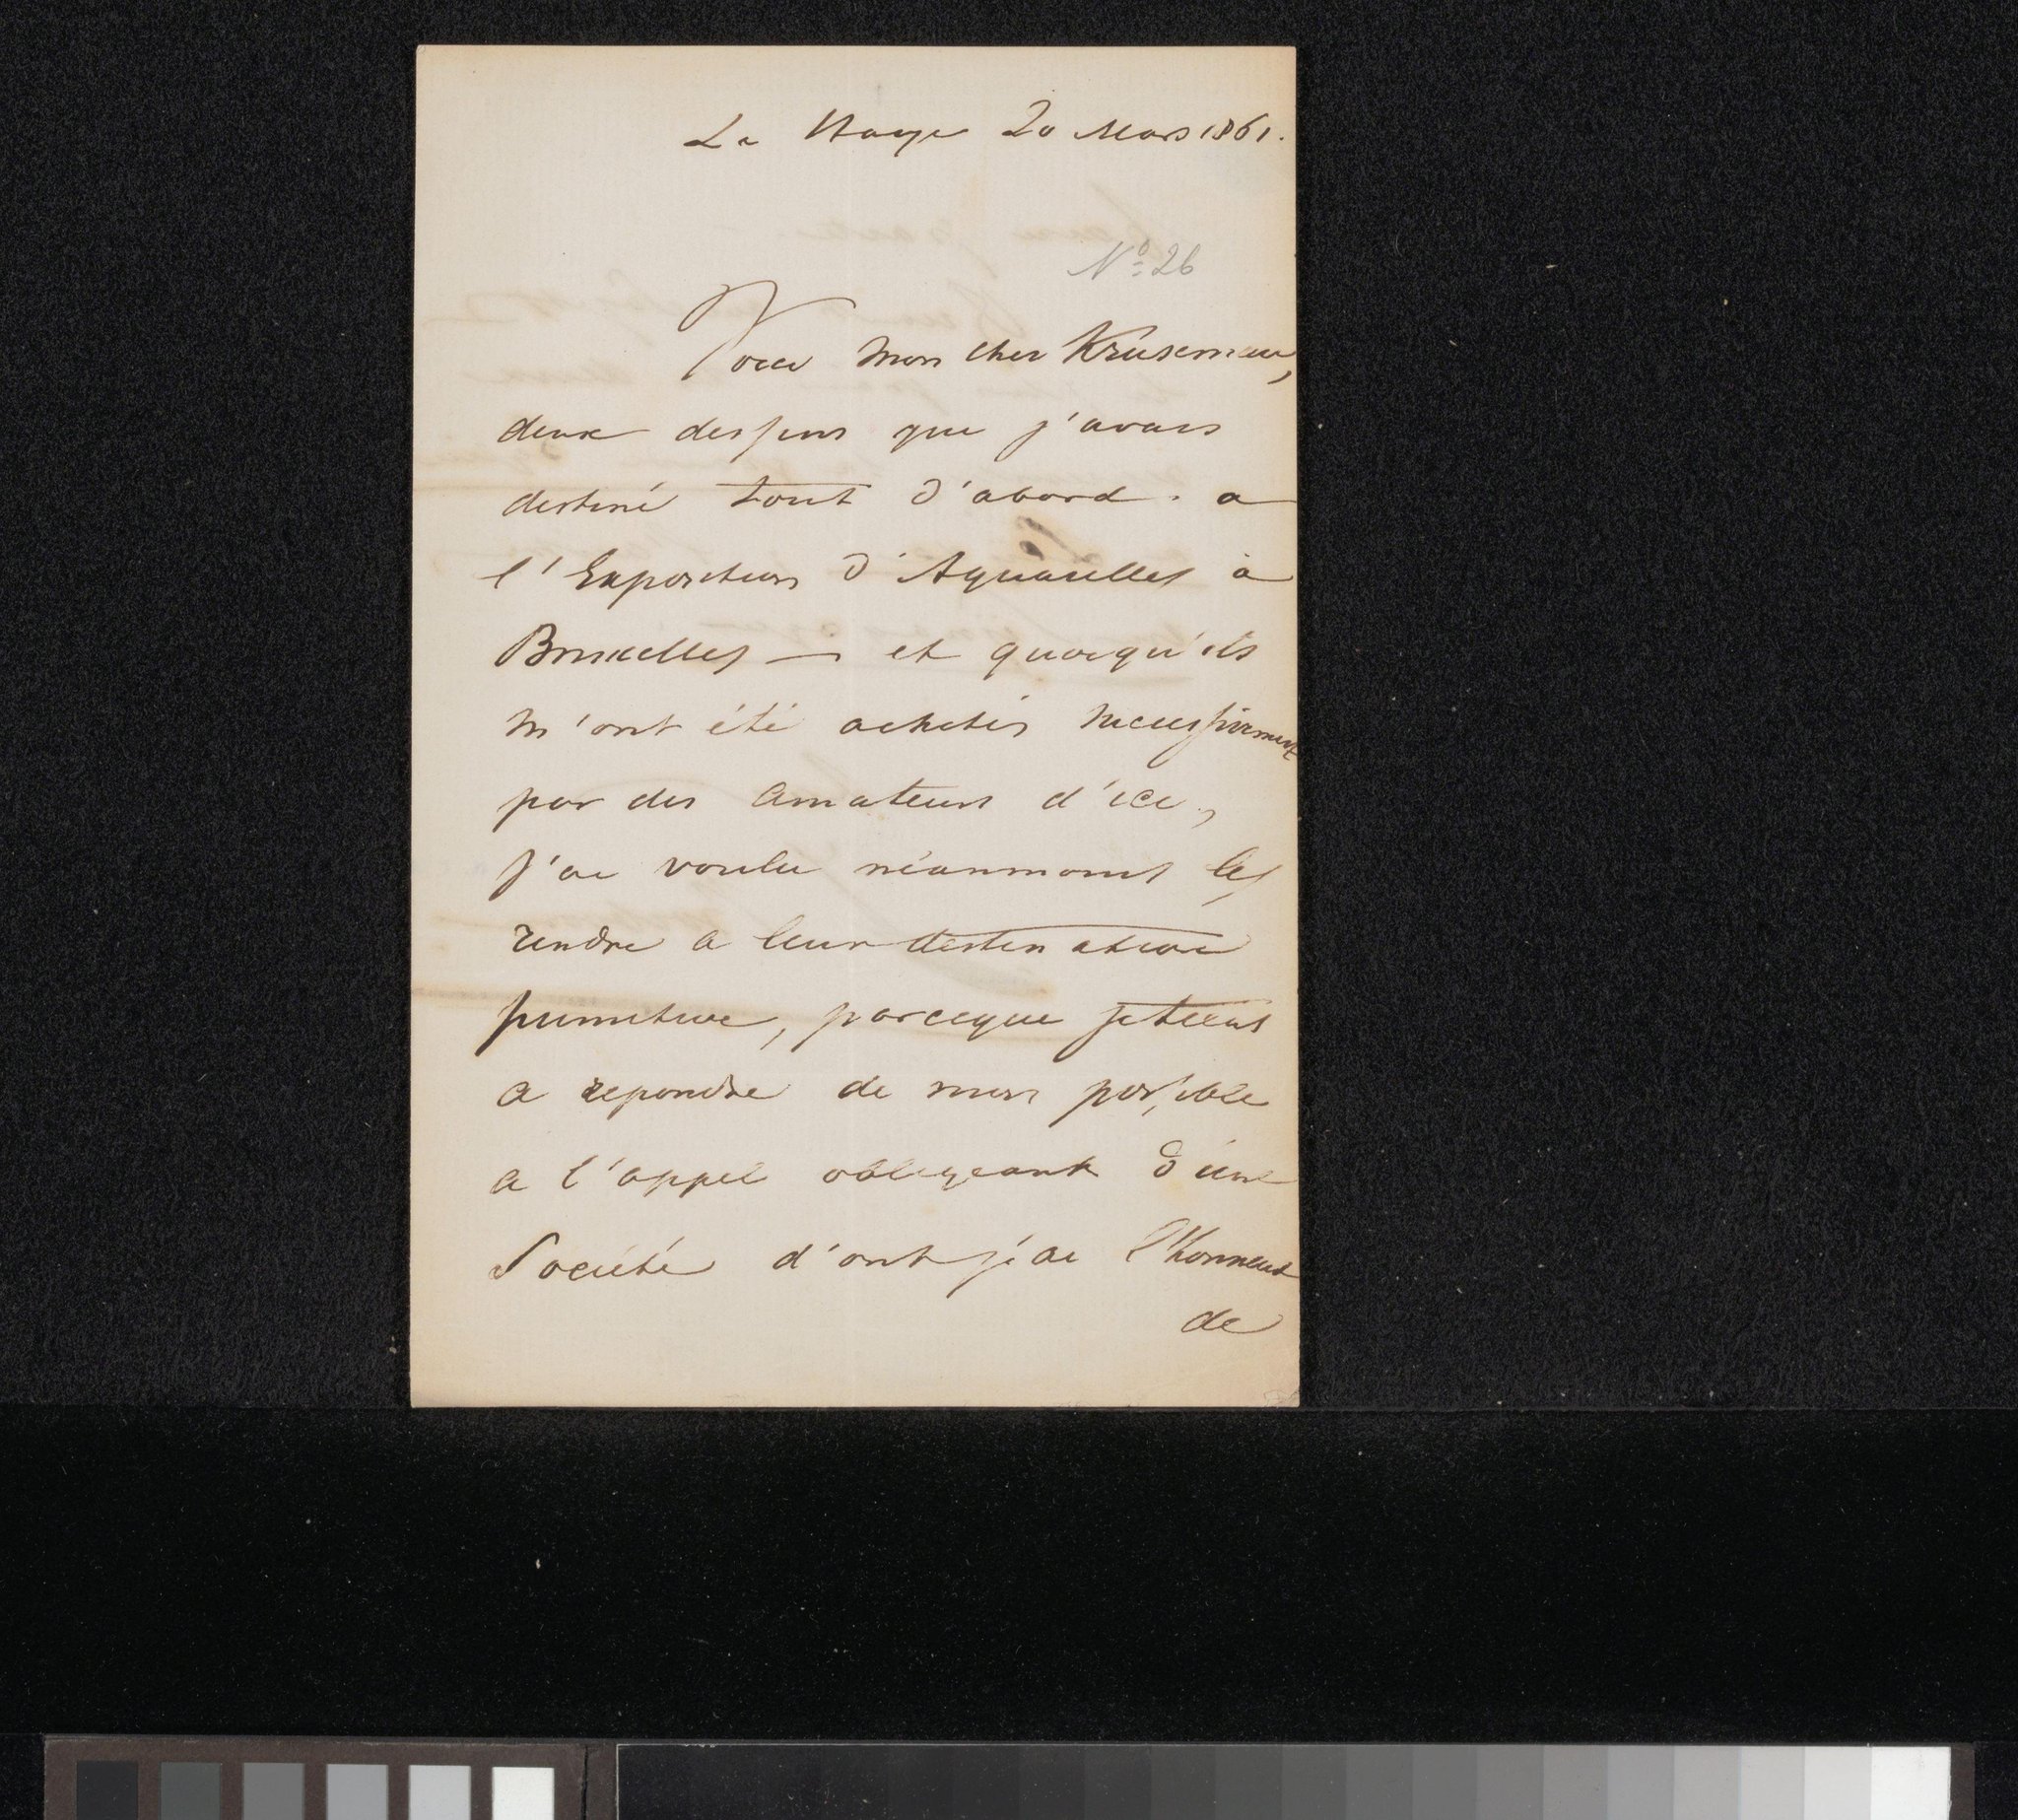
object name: letter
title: Brief aan Frederik Marinus Kruseman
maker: johannes bosboom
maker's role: draughtsman, painter, print maker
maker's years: 1817-1891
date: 1861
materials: ink, paper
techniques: pen, writing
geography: the hague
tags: haarlem, brussels, painter, draughtsman, frederik marinus kruseman, drawing, exhibition ~ art